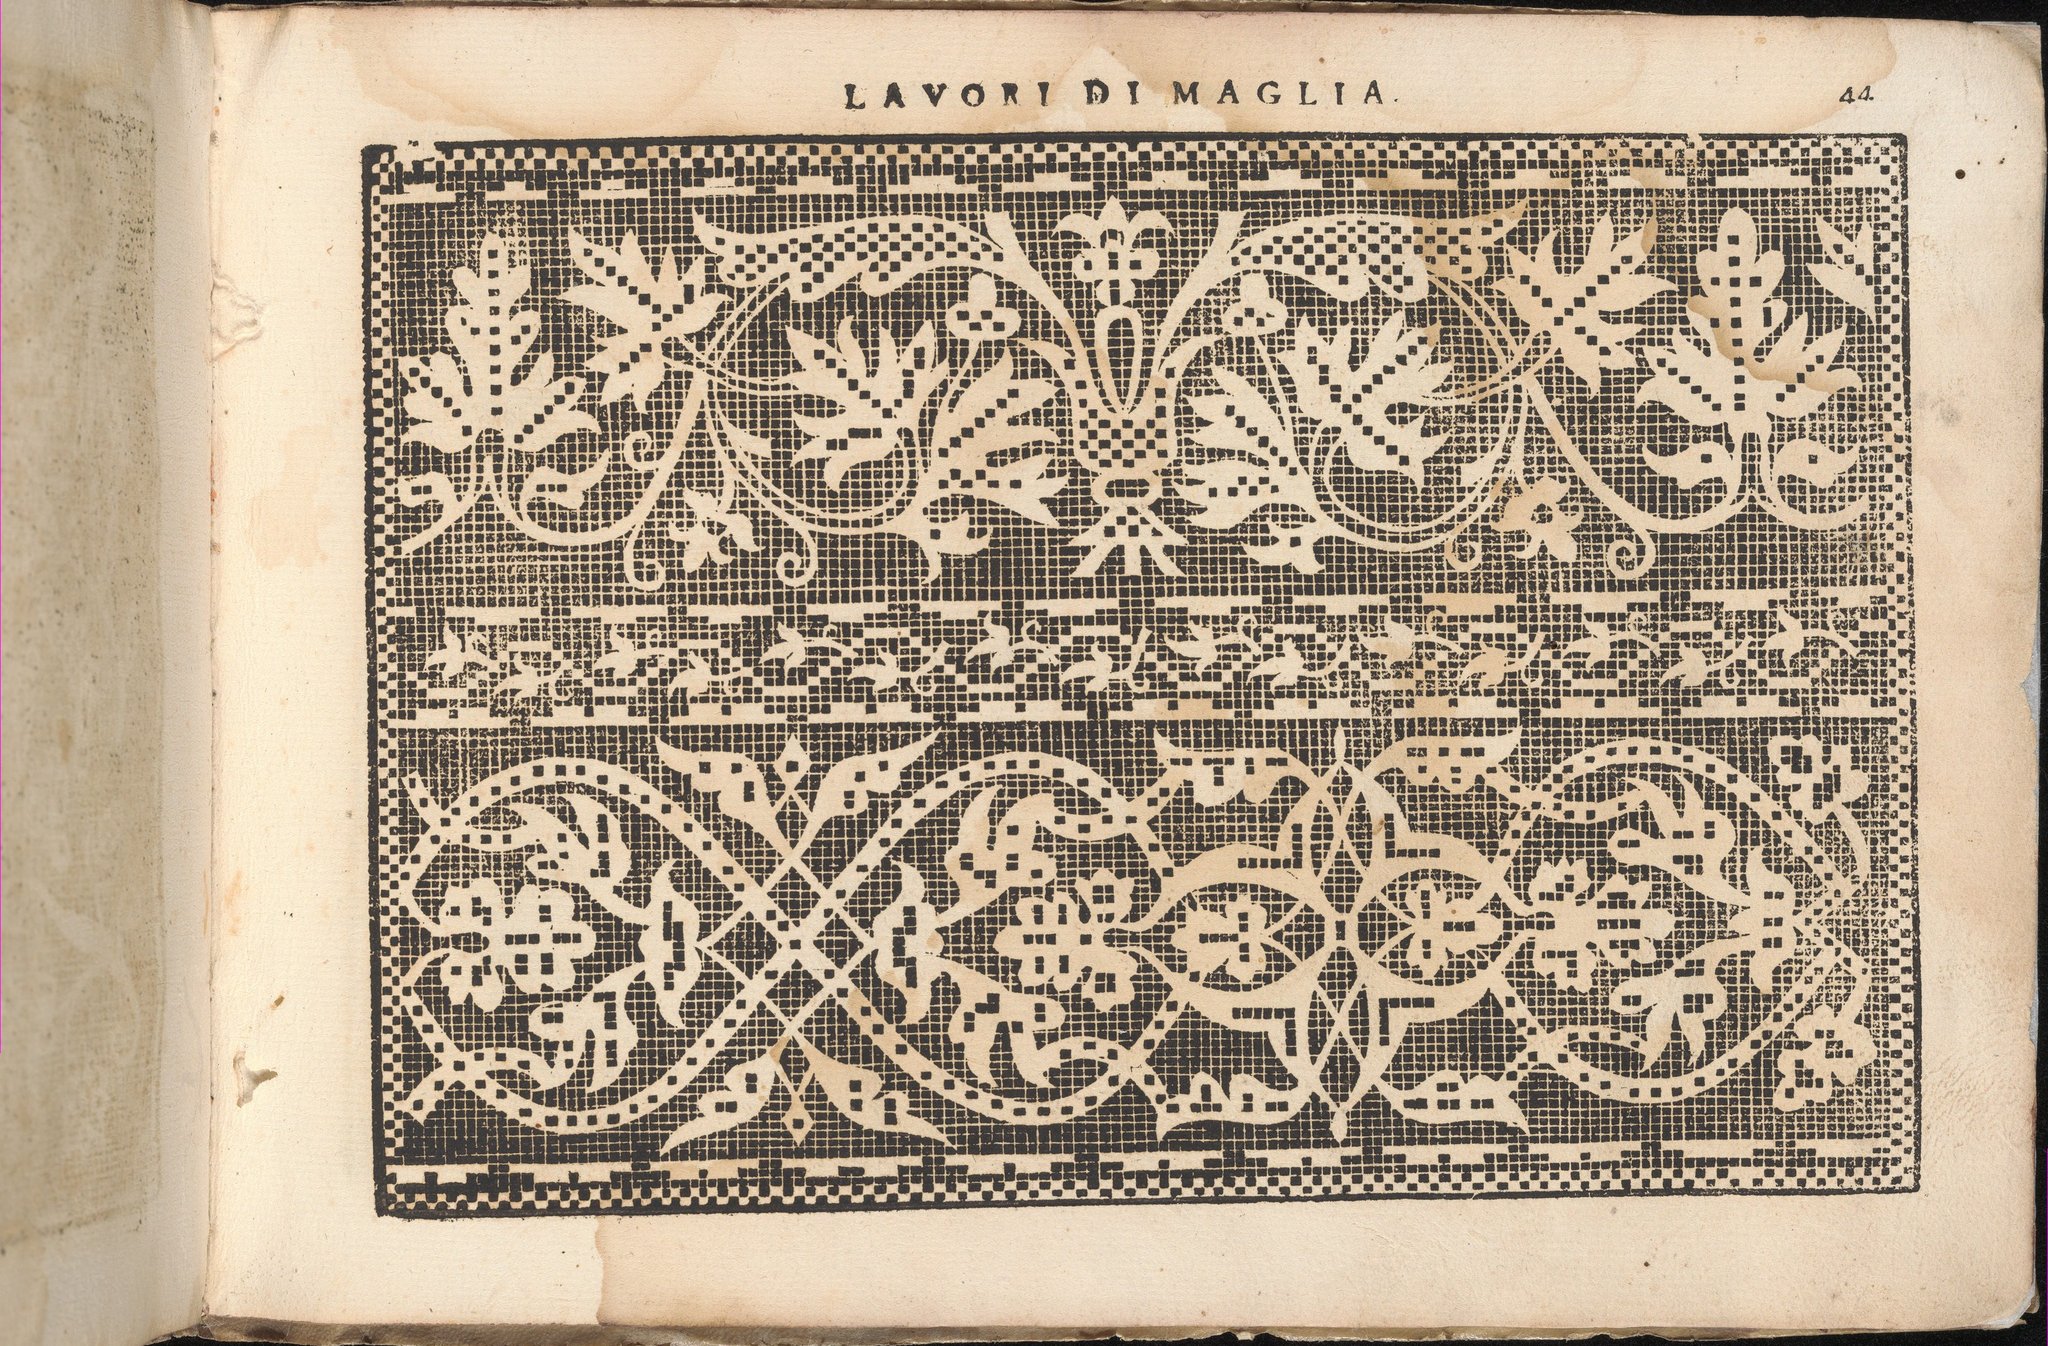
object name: book print ornament architecture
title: Teatro delle Nobili et Virtuose Donne..., page 44 (recto)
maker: isabella catanea parasole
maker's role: author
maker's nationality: italian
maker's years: 1565-1625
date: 1616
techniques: engraving, woodcut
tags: flowers